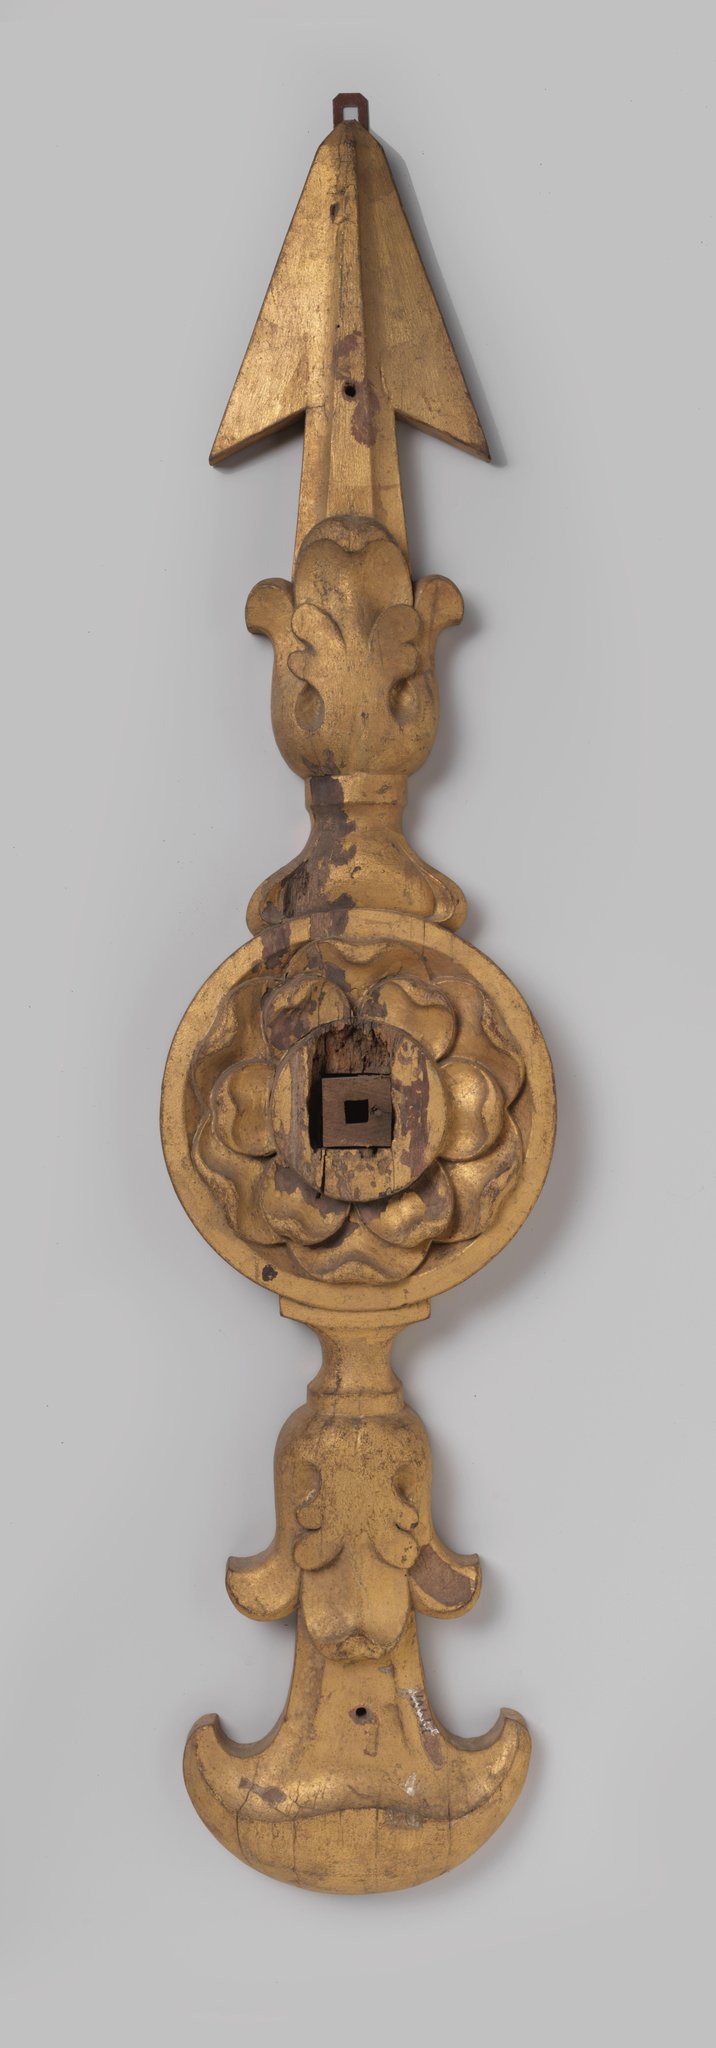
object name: architectural element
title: Wijzer afkomstig van het uurwerk in de stadstoren te Middelburg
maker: Anonymous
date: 1600-1699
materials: wood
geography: northern netherlands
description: Wijzer afkomstig van het uurwerk in de stadstoren te Middelburg. Deels oud, deels van latere datum. Goudverf. De punt is afgebroken.